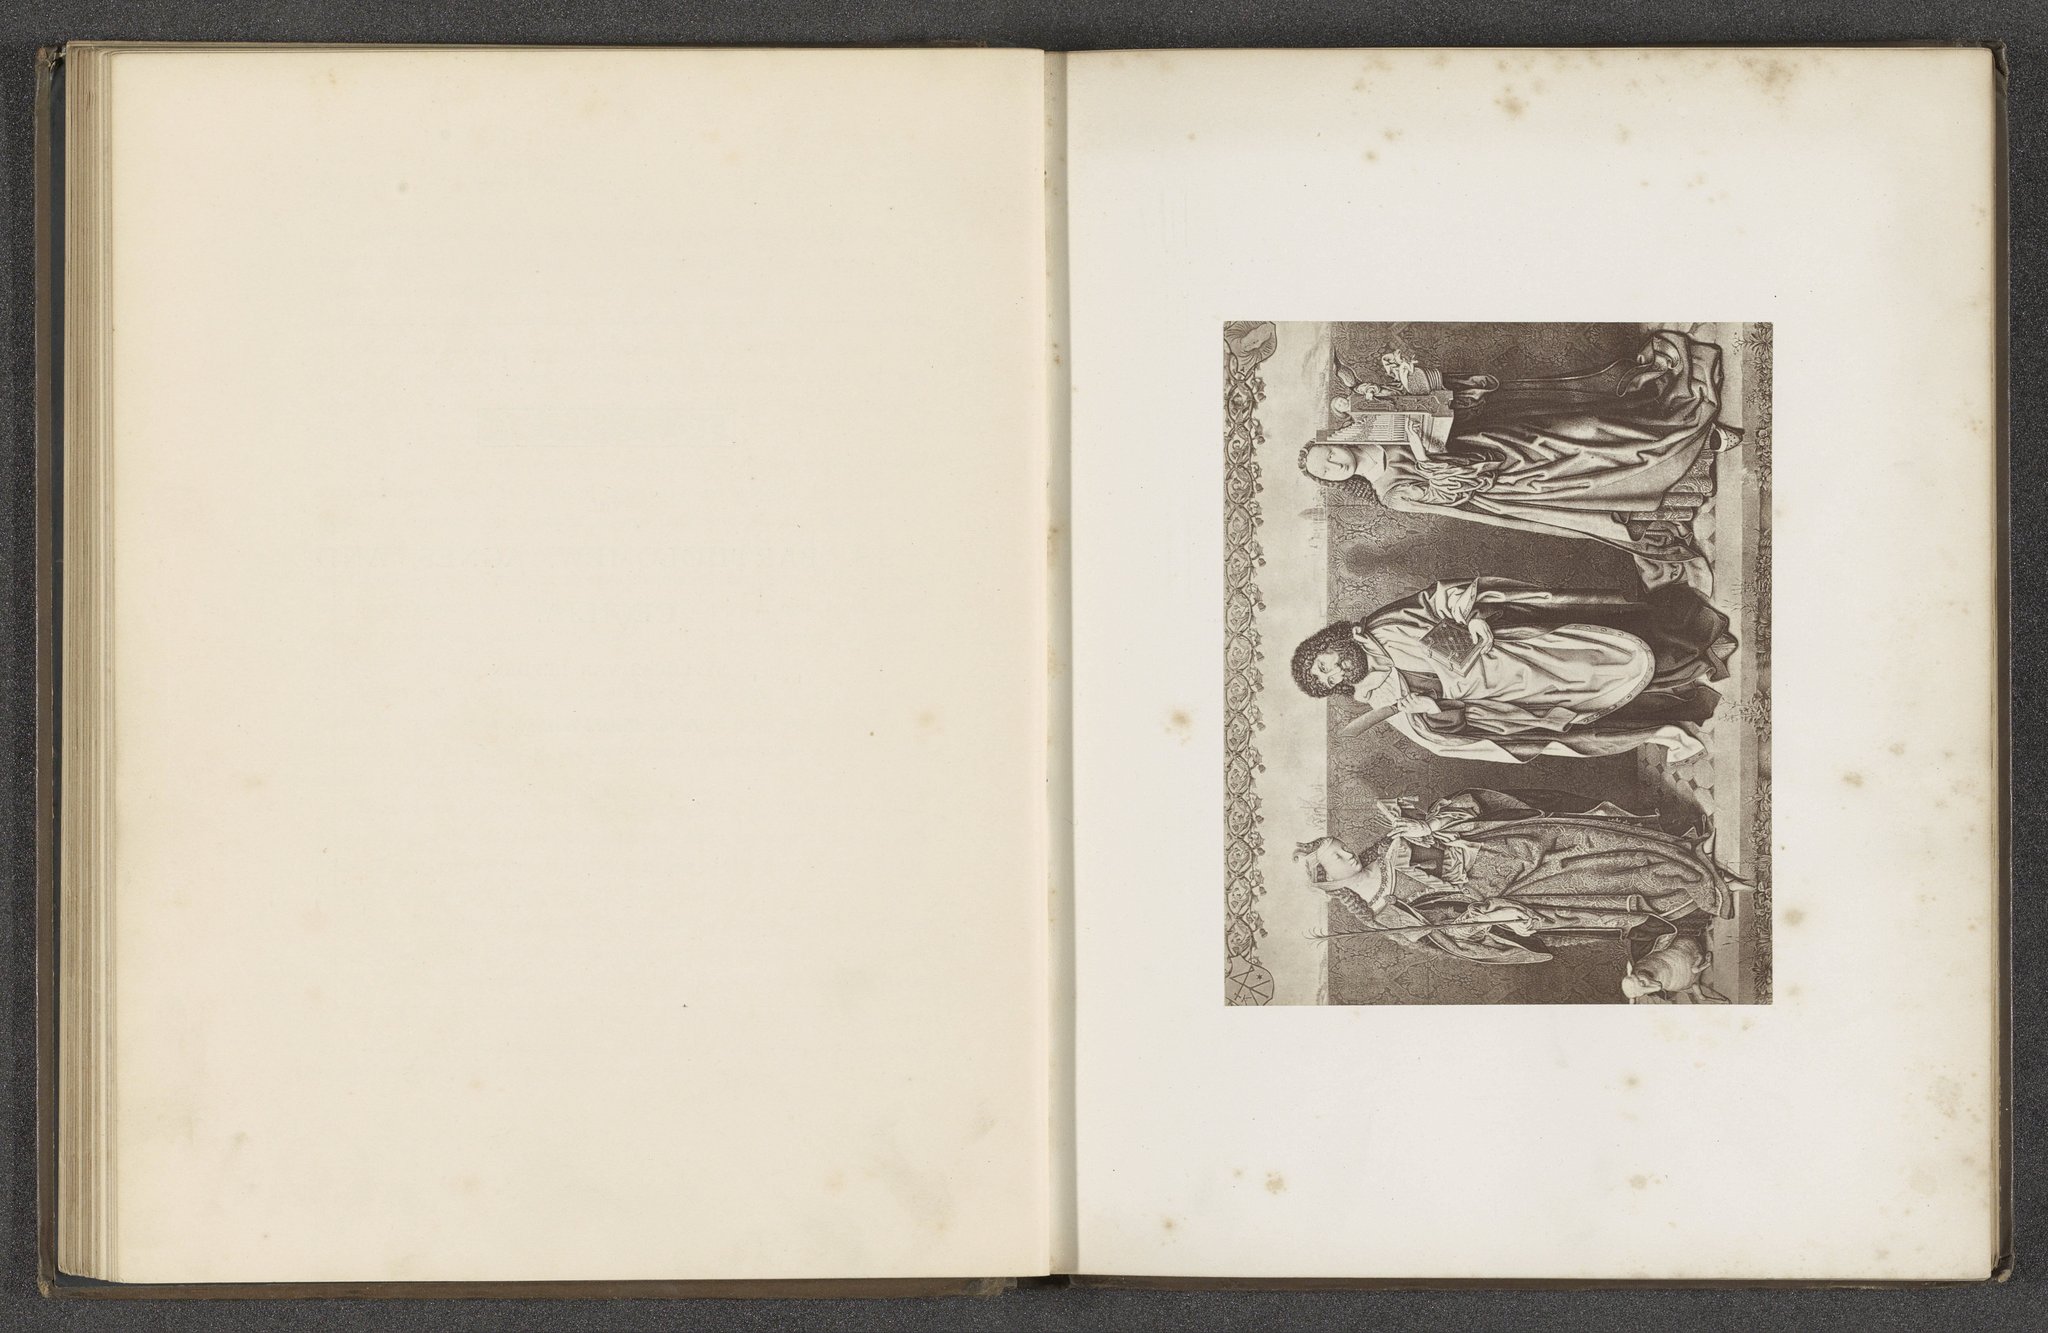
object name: photomechanical print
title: Fotoreproductie van een prent van een schilderij, voorstellende de heilige Bartholomeus, Agnes en Cecilia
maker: Anonymous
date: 1859-1869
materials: paper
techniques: woodburytype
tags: the virgin martyr cecilia of rome; possible attributes: falcon, musical instruments, organ, wreath of roses and lilies, the apostle bartholomew; possible attributes: book, devil or dragon at feet, knife, scroll, flayed skin, staff, the virgin martyr agnes of rome; possible attributes: lamb, ring